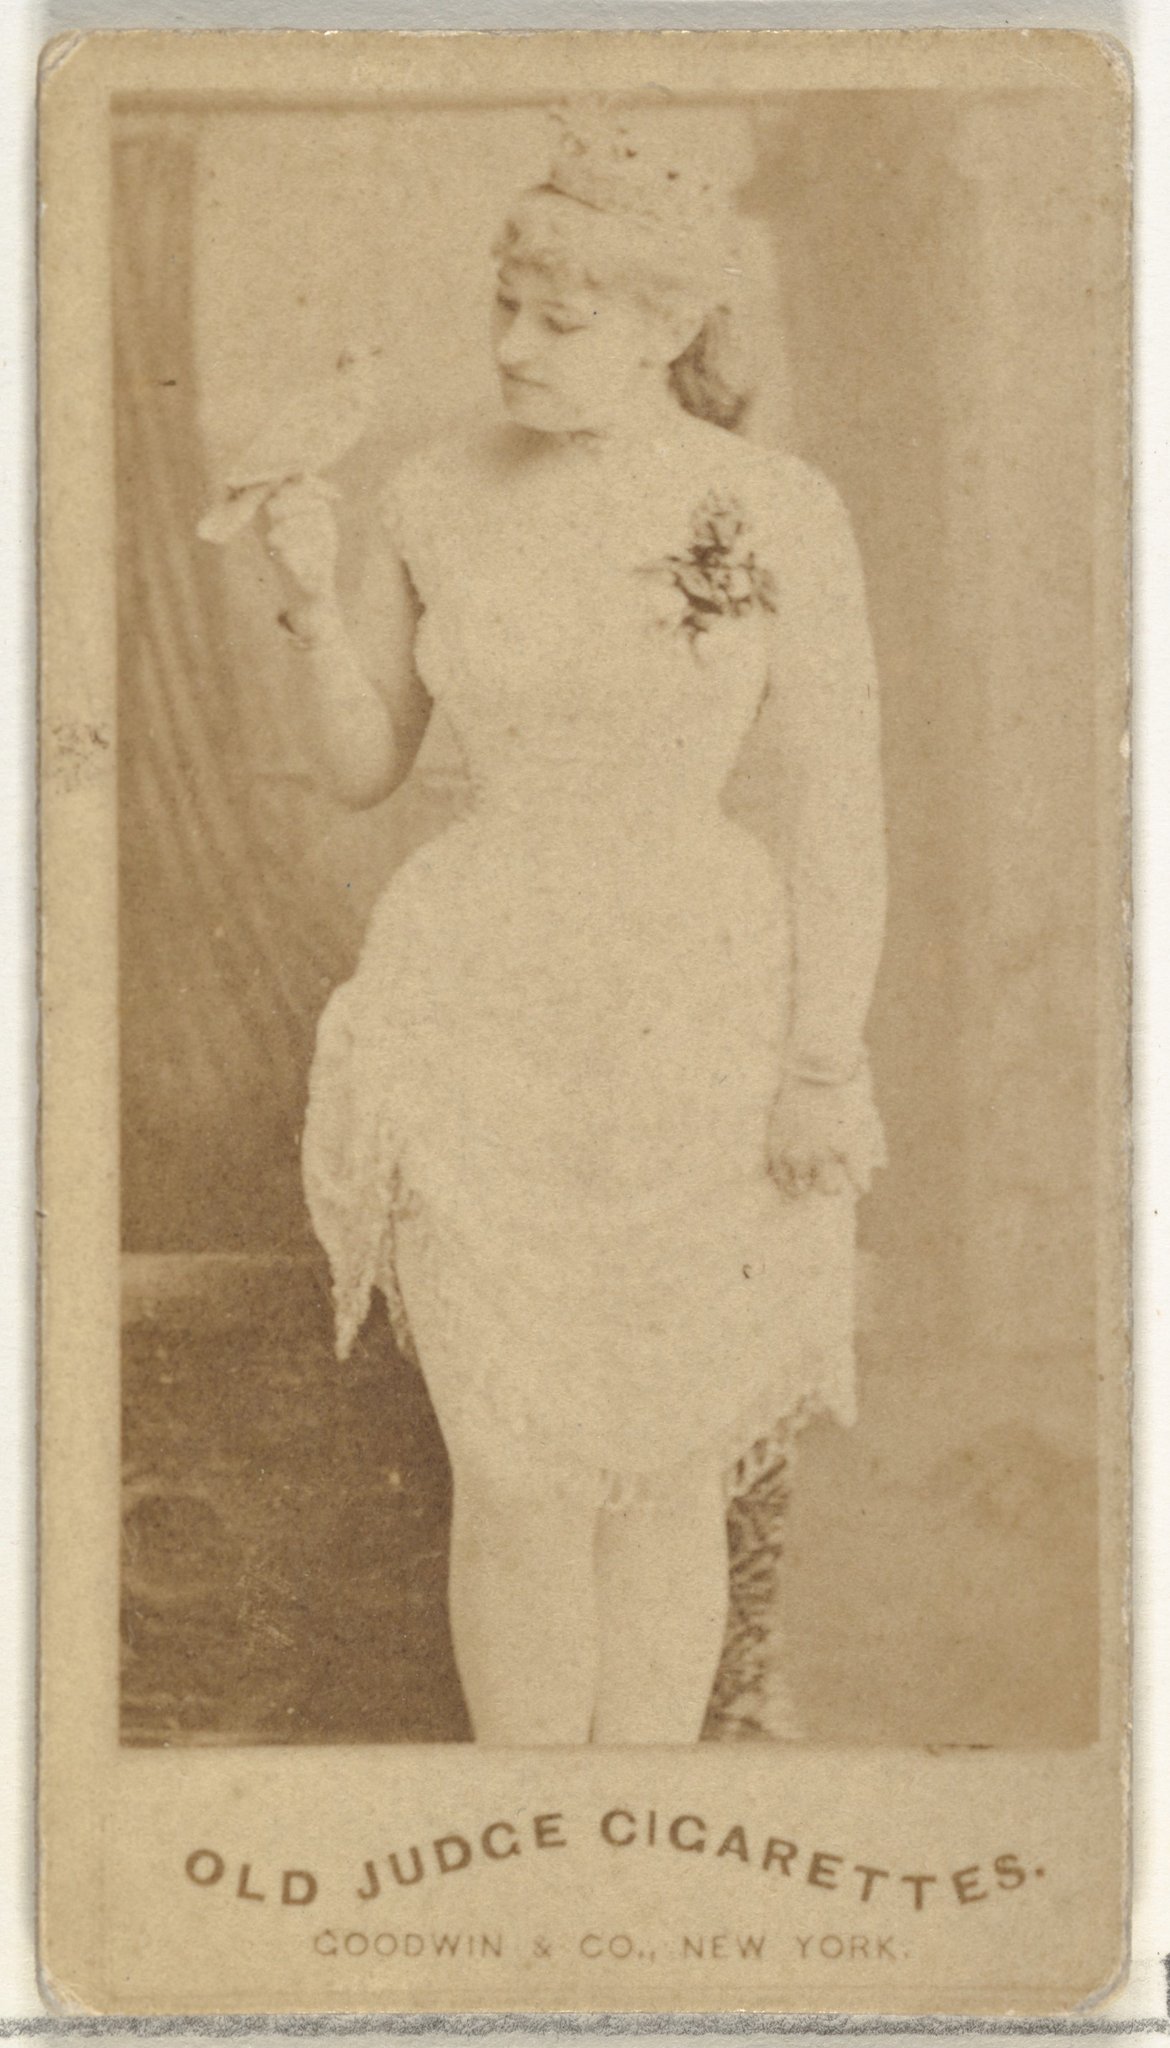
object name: photograph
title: From the Actors and Actresses series (N171) for Old Judge Cigarettes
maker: goodwin & company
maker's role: publisher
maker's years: 1850-1950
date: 1886-1890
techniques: albumen silver print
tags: portraits,women,actresses